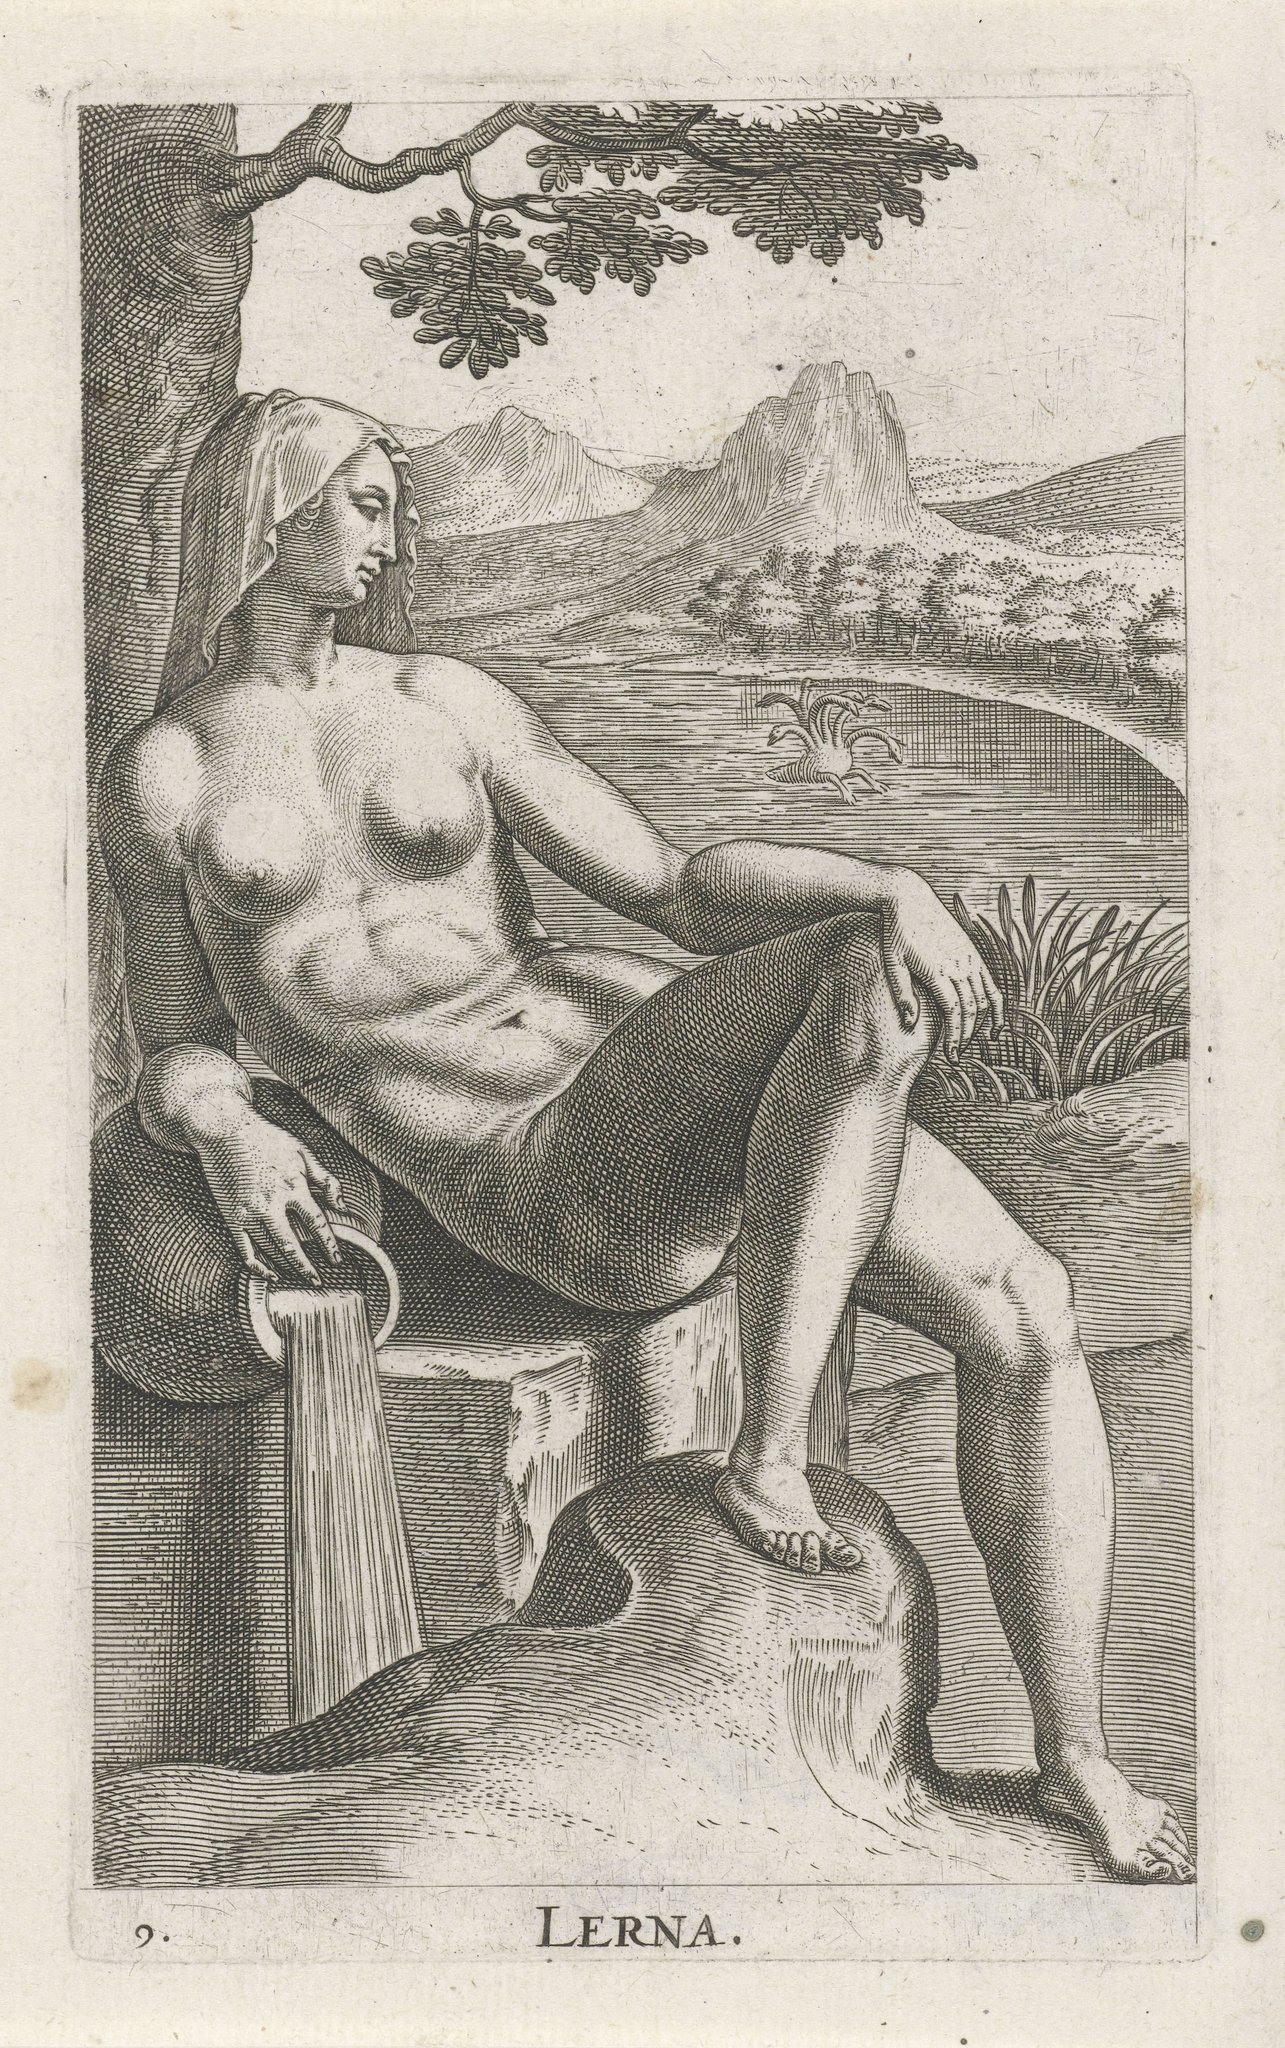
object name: print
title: Nimpharum oceanitidum, ephydridum potamidum naiadum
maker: philips galle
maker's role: print maker, publisher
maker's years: 1537-1612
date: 1587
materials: paper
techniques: engraving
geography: antwerp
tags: hydra of lerna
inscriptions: collector's mark: Lugt 2228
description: De waternimf Lerna, gezeten op een stenen blok. In de achtergrond de hydra van Lerna. De prent maakt deel uit van een zeventiendelige serie over stroom- en waternimfen.